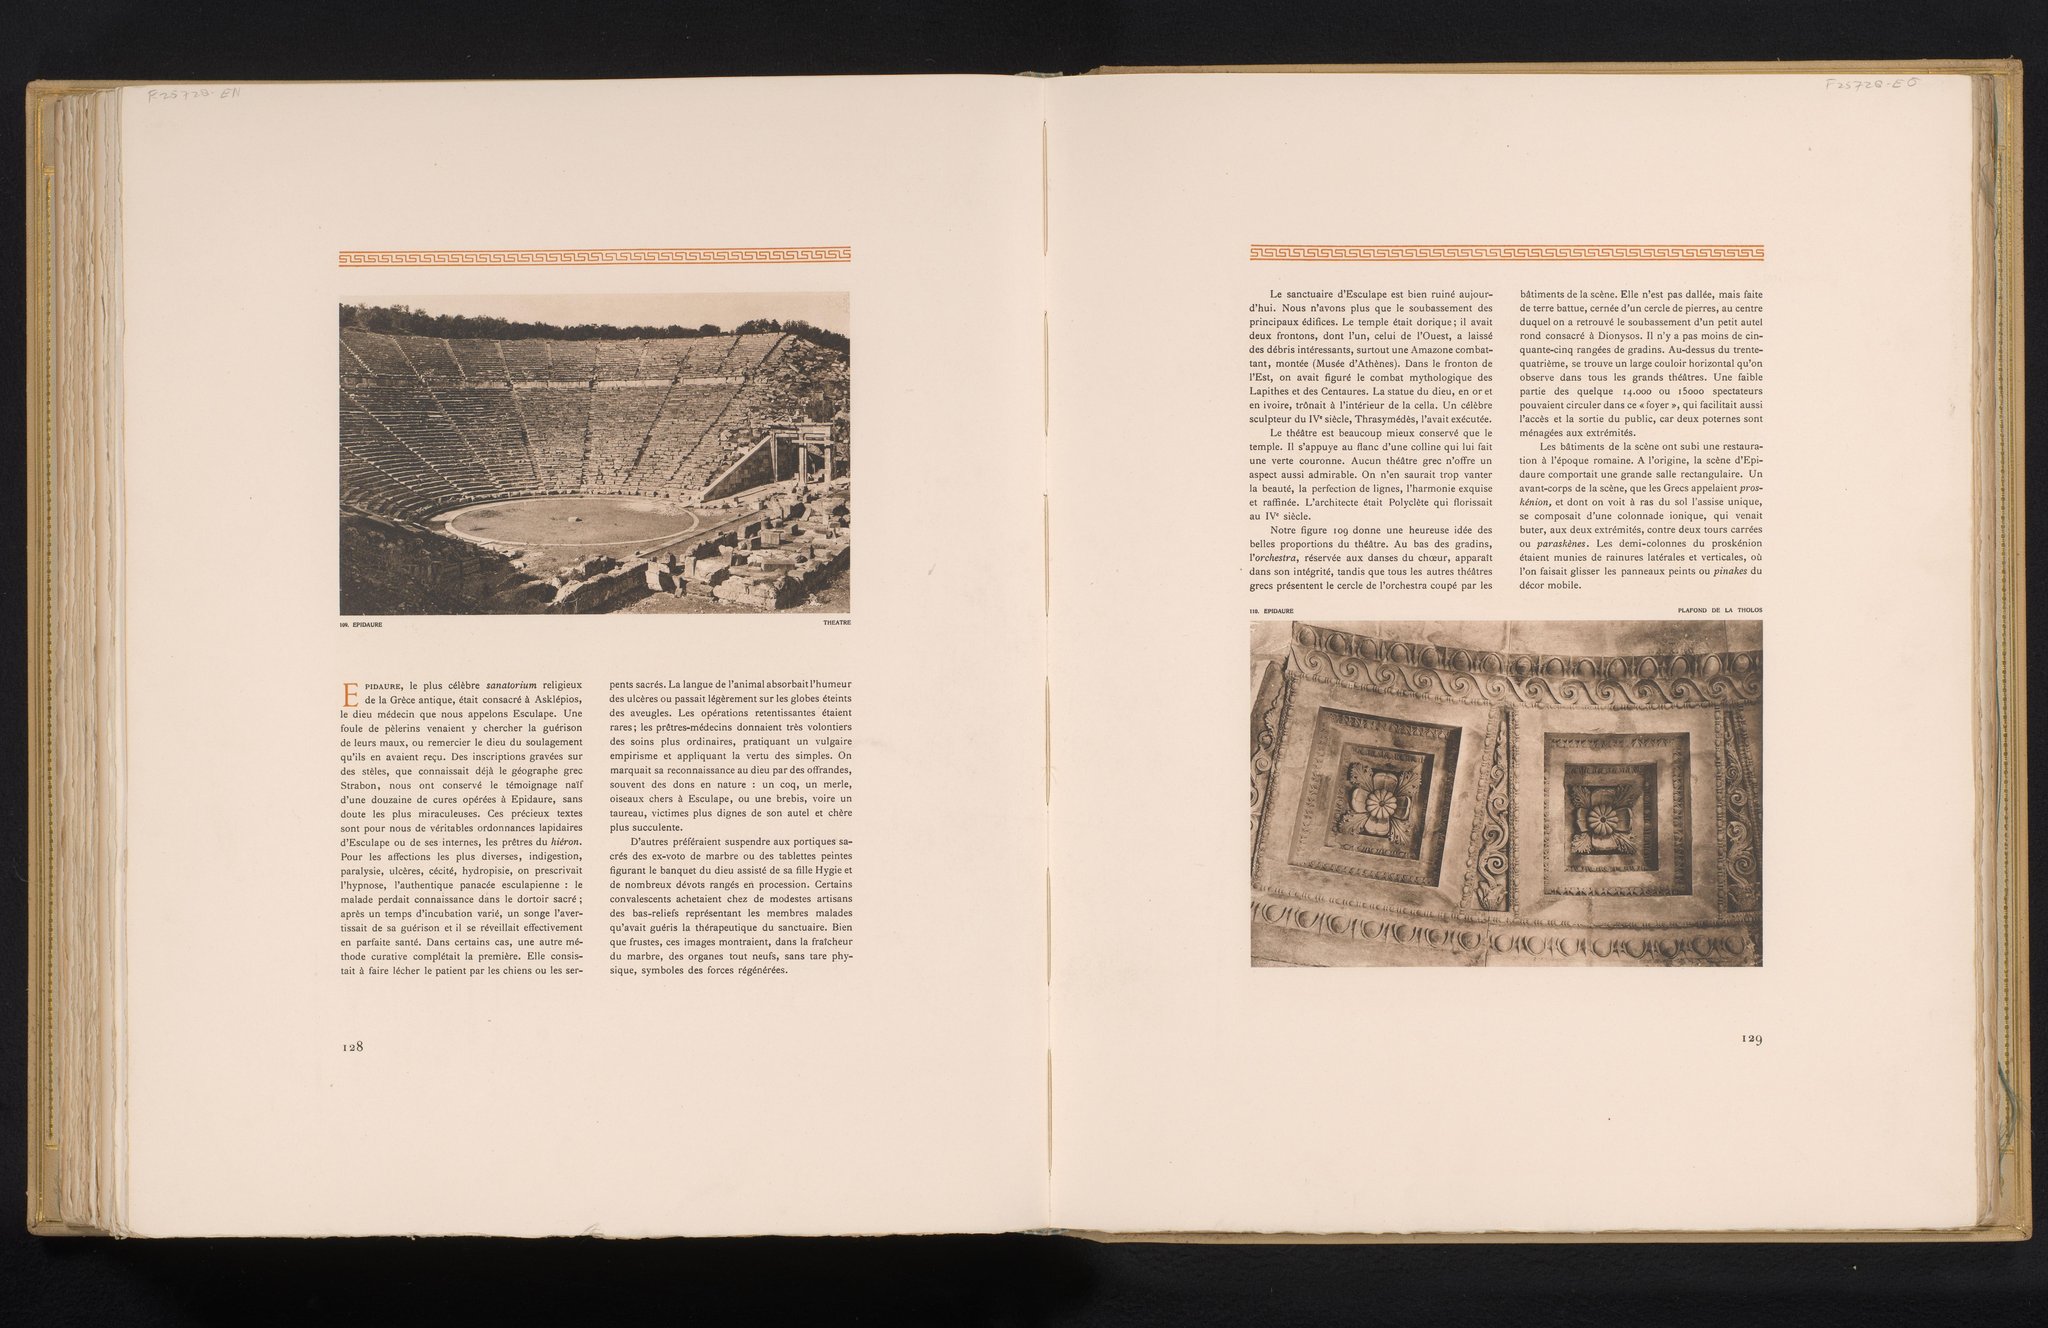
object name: photomechanical print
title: Reliëfs aan het plafond van de Tholos van Epidaurus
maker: frédéric boissonnas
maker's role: fotograaf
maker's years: 1858-1946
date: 1905-1910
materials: paper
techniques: photograph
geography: berlin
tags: sculpture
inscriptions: number: ‘110.’